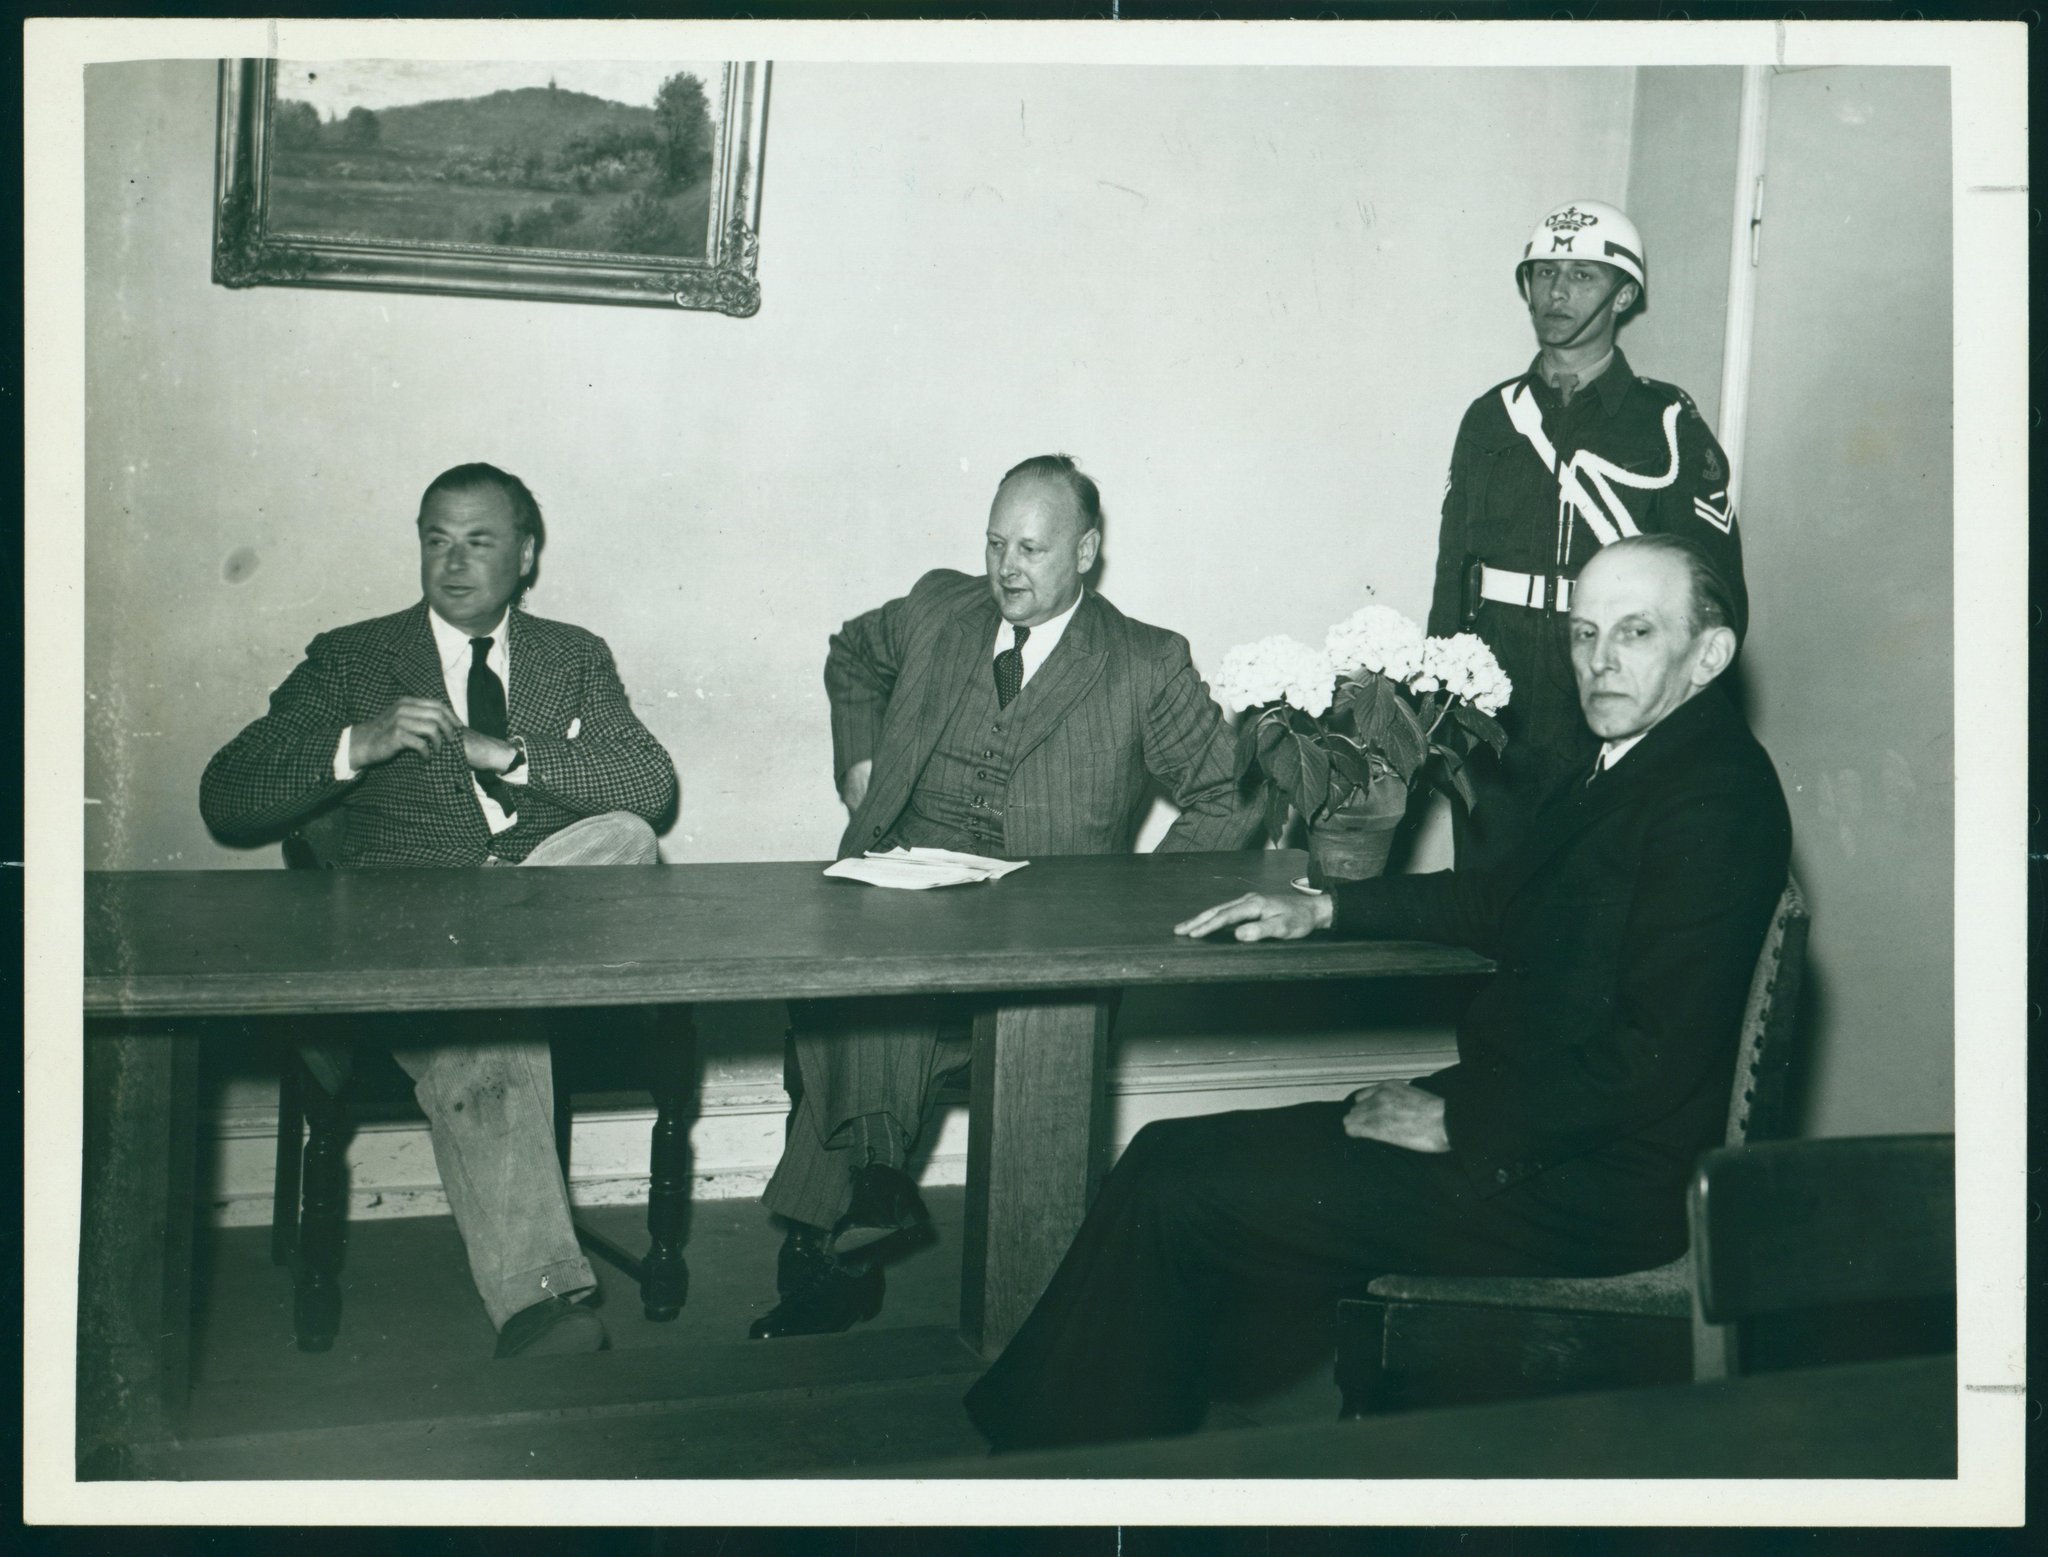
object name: documentary photograph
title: Tekening bestuursoverdracht Elten in het stadhuis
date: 1949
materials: photographic support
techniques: photography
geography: elten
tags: mayor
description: In het stadhuis te Elten wordt de bestuursoverdracht getekend. Met van links naar rechts de Britse officier J.S. Collings, de landdrost A. Blaauboer en voormalig burgemeester baron Lochner von Hüttenbach in het bijzin van een marechaussee.